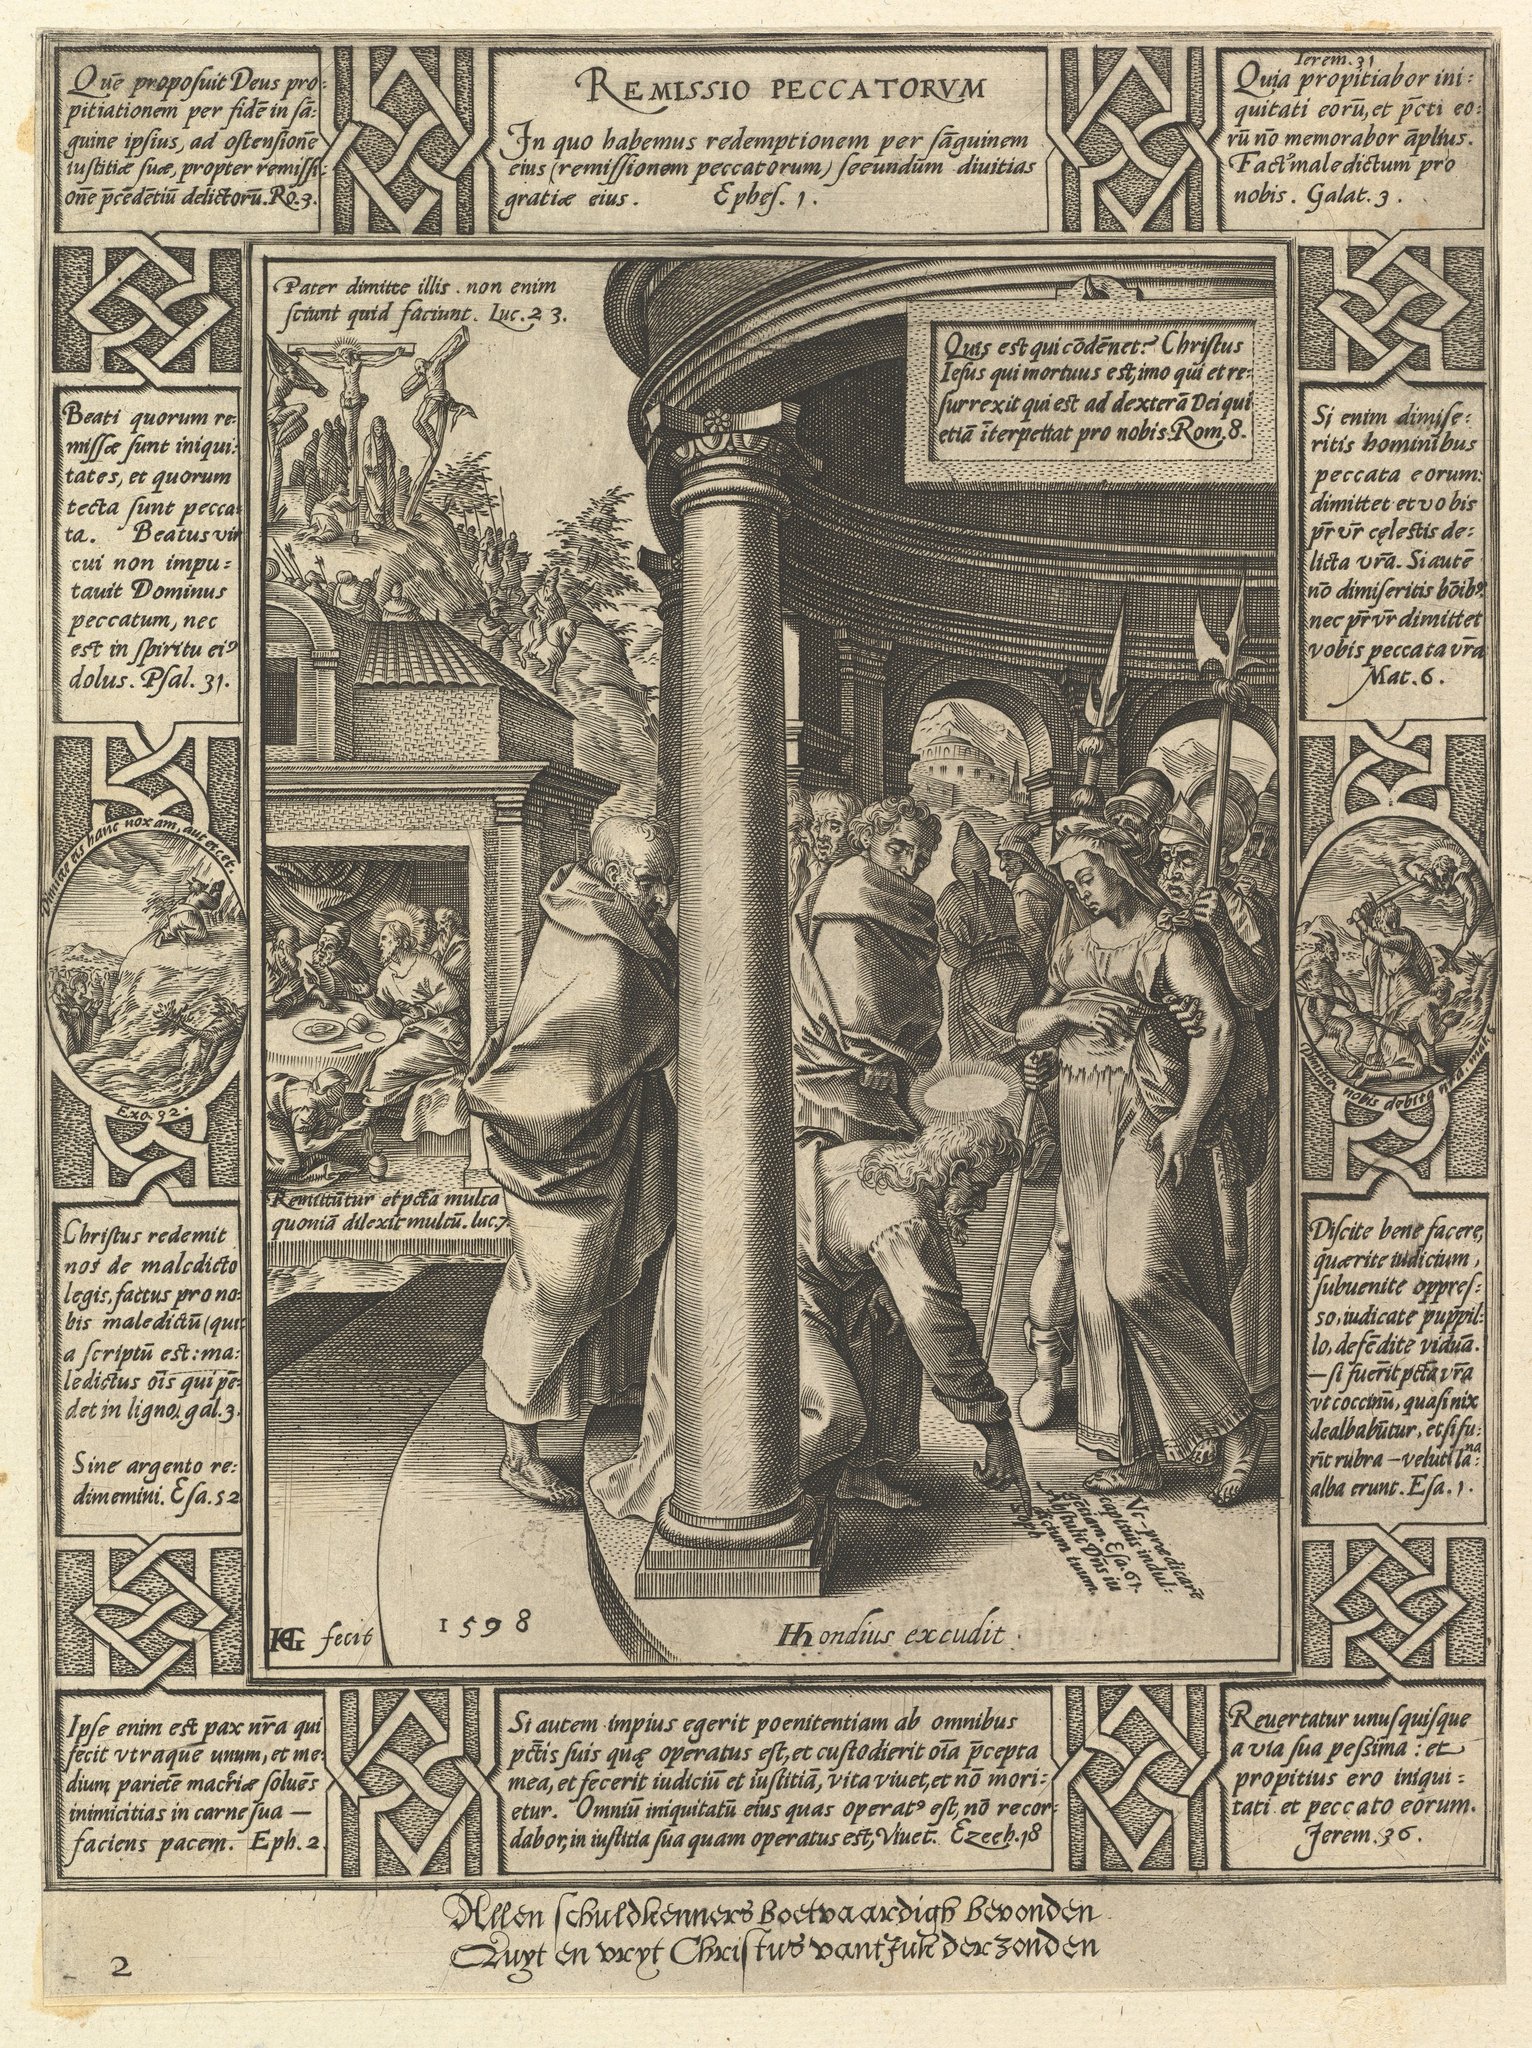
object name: print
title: Remissio Peccatorum, from "The Allegories on the Christian Creed"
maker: hendrick goltzius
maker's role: artist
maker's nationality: netherlandish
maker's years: 1558-1617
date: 1598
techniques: engraving